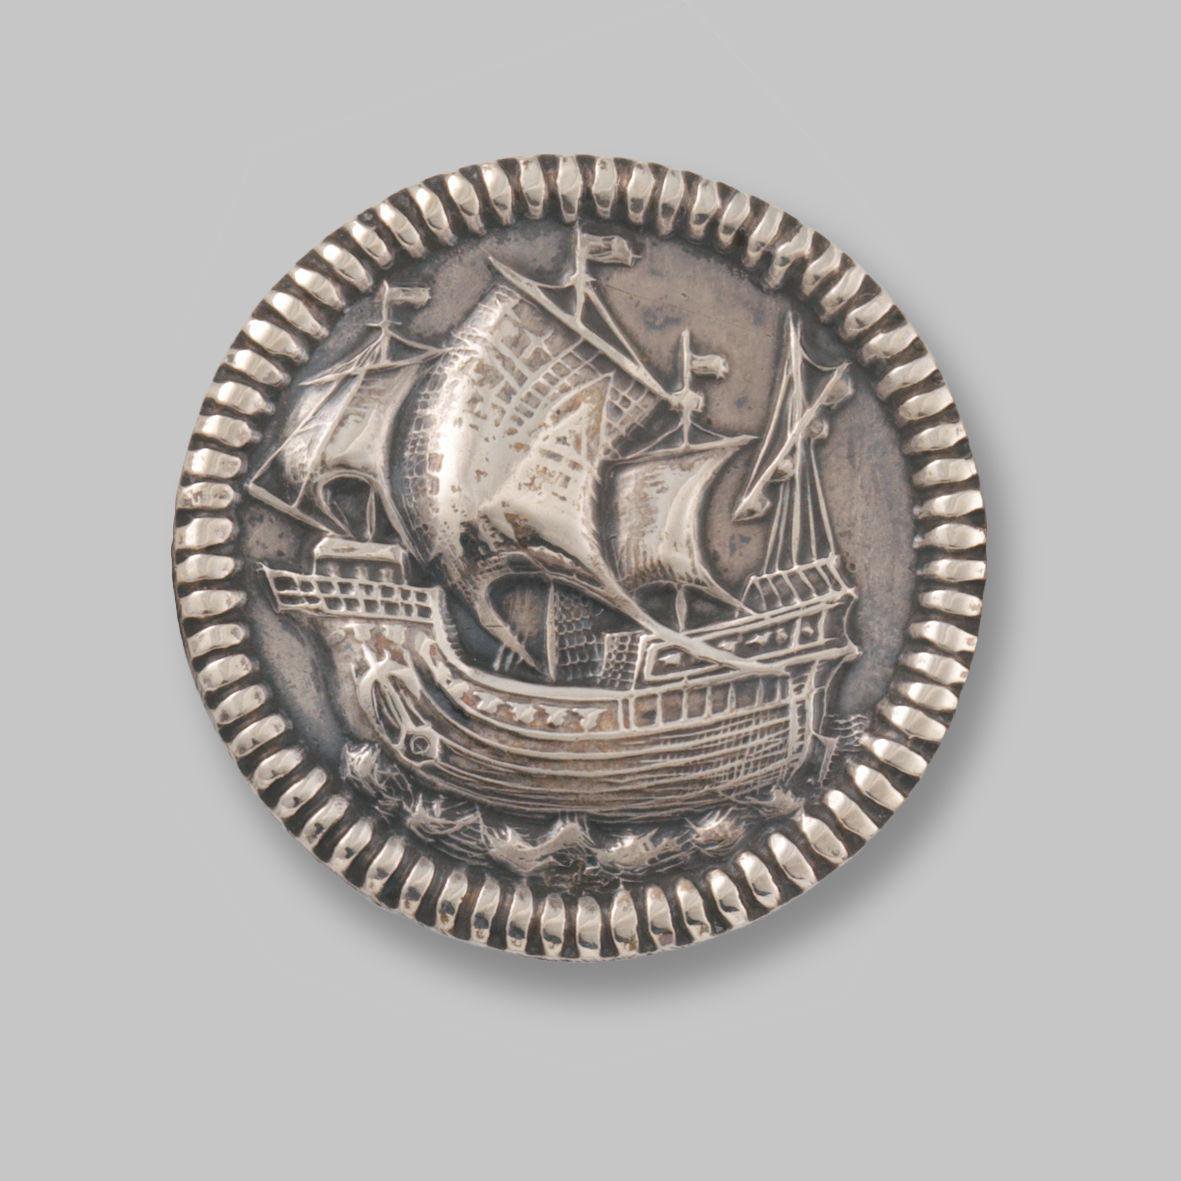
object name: button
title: Knoop met voorstelling van een driemaster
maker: Anonymous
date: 1850-1900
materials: silver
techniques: casting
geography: netherlands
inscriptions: alloy mark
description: Knoop van gegoten zilver, rond, met op de voorzijde een driemaster omgeven door een geribde rand. Aan de achterzijde is een uit gebogen draad vervaardigd oog bevestigd.